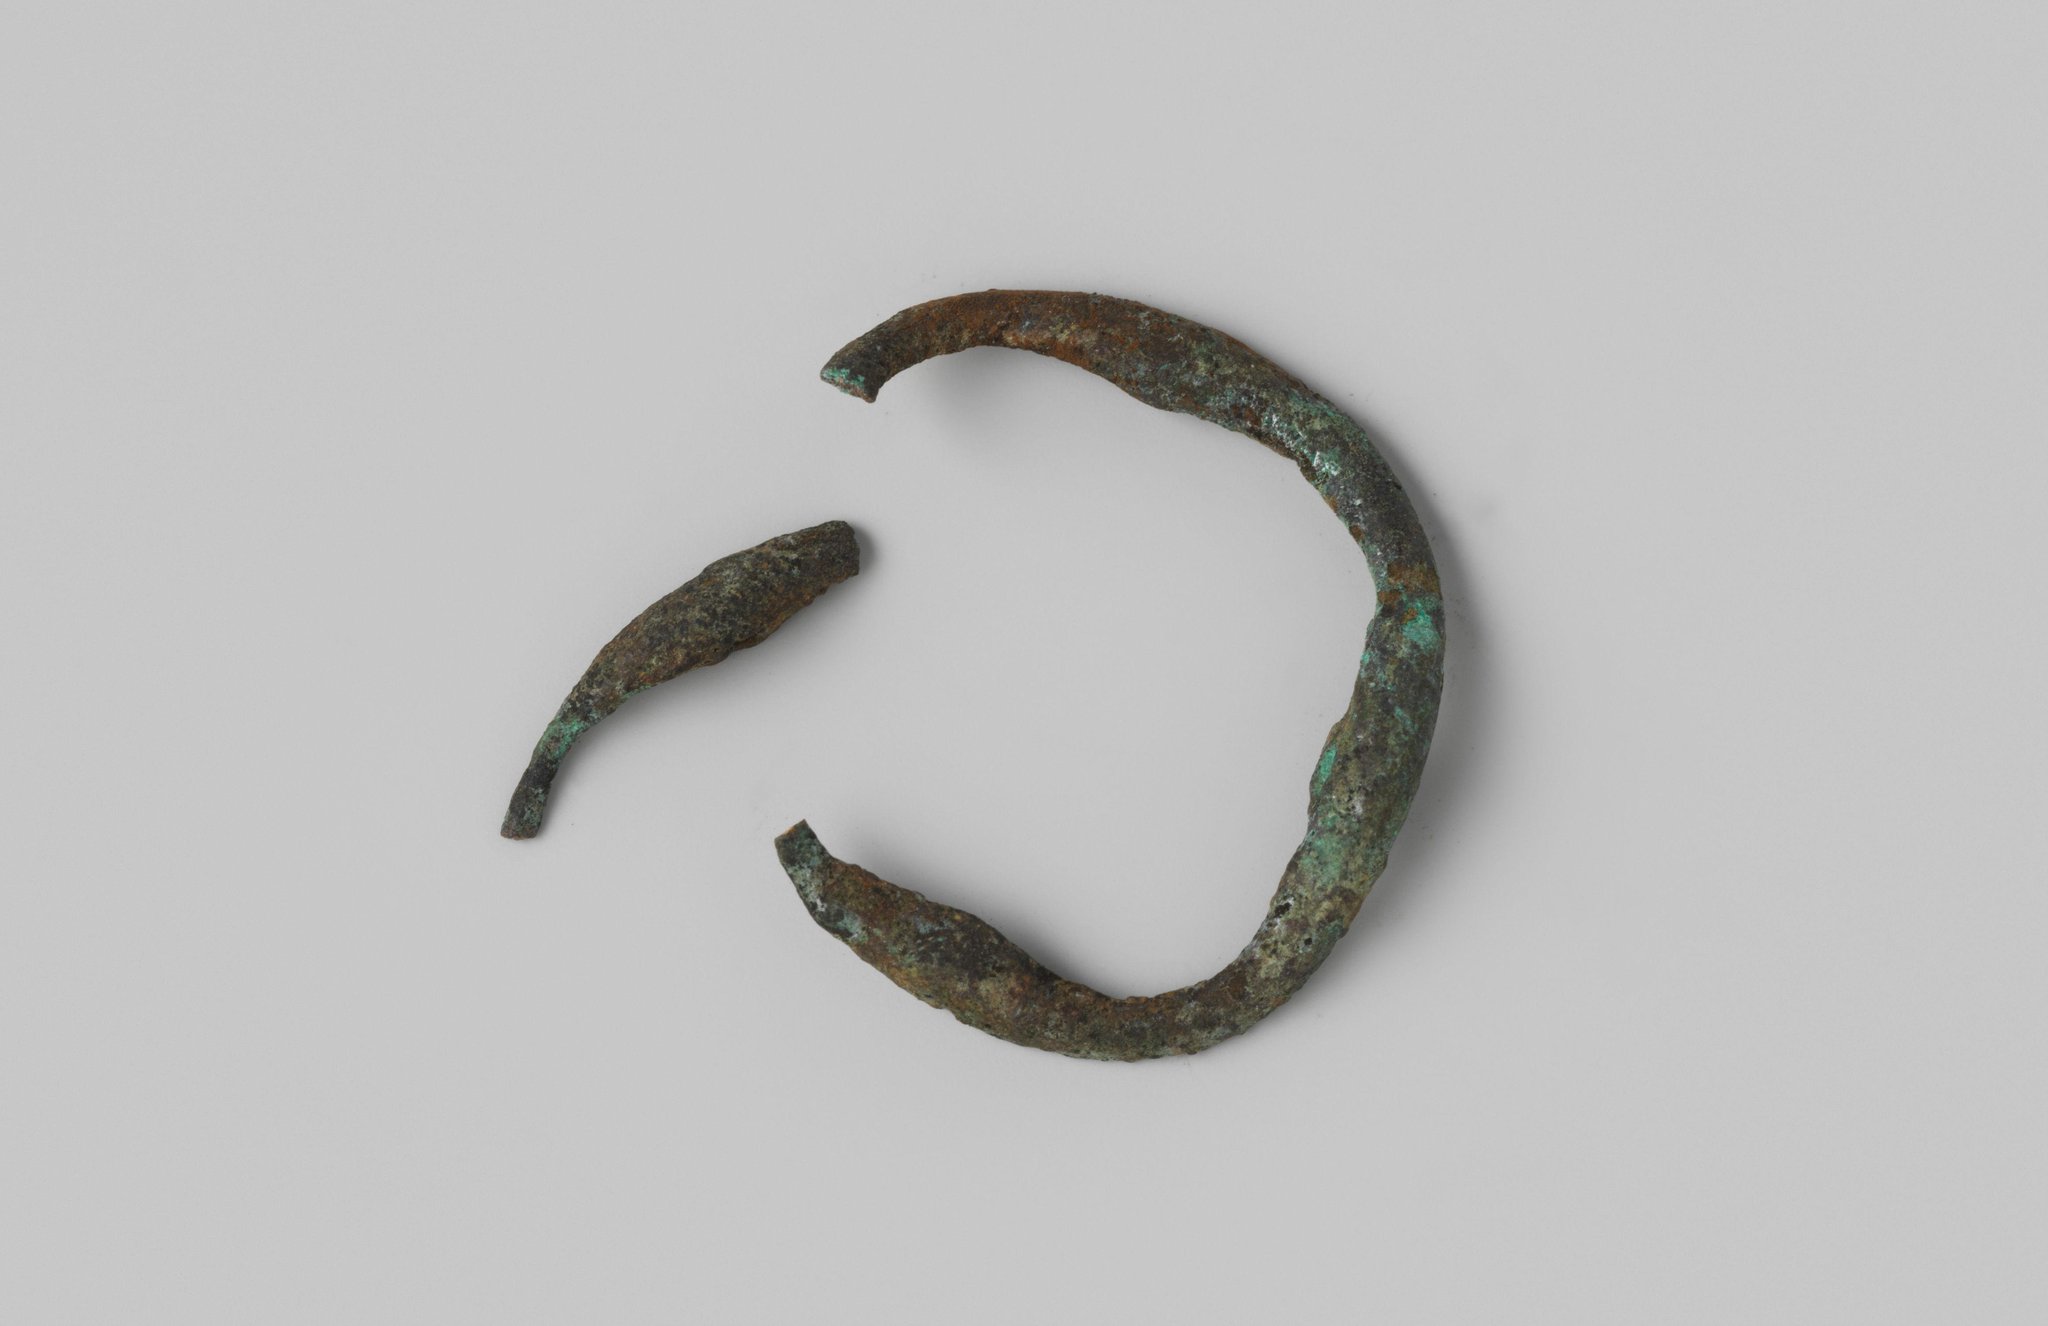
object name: knee buckle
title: Fragmenten kniegesp uit het wrak van de Oost-Indiëvaarder Hollandia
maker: Anonymous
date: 1700-1743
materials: copper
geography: netherlands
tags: verenigde oostindische compagnie, hollandia (schip), annet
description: Buckle, chape buckle, knee buckle; ring, eroded, plain.